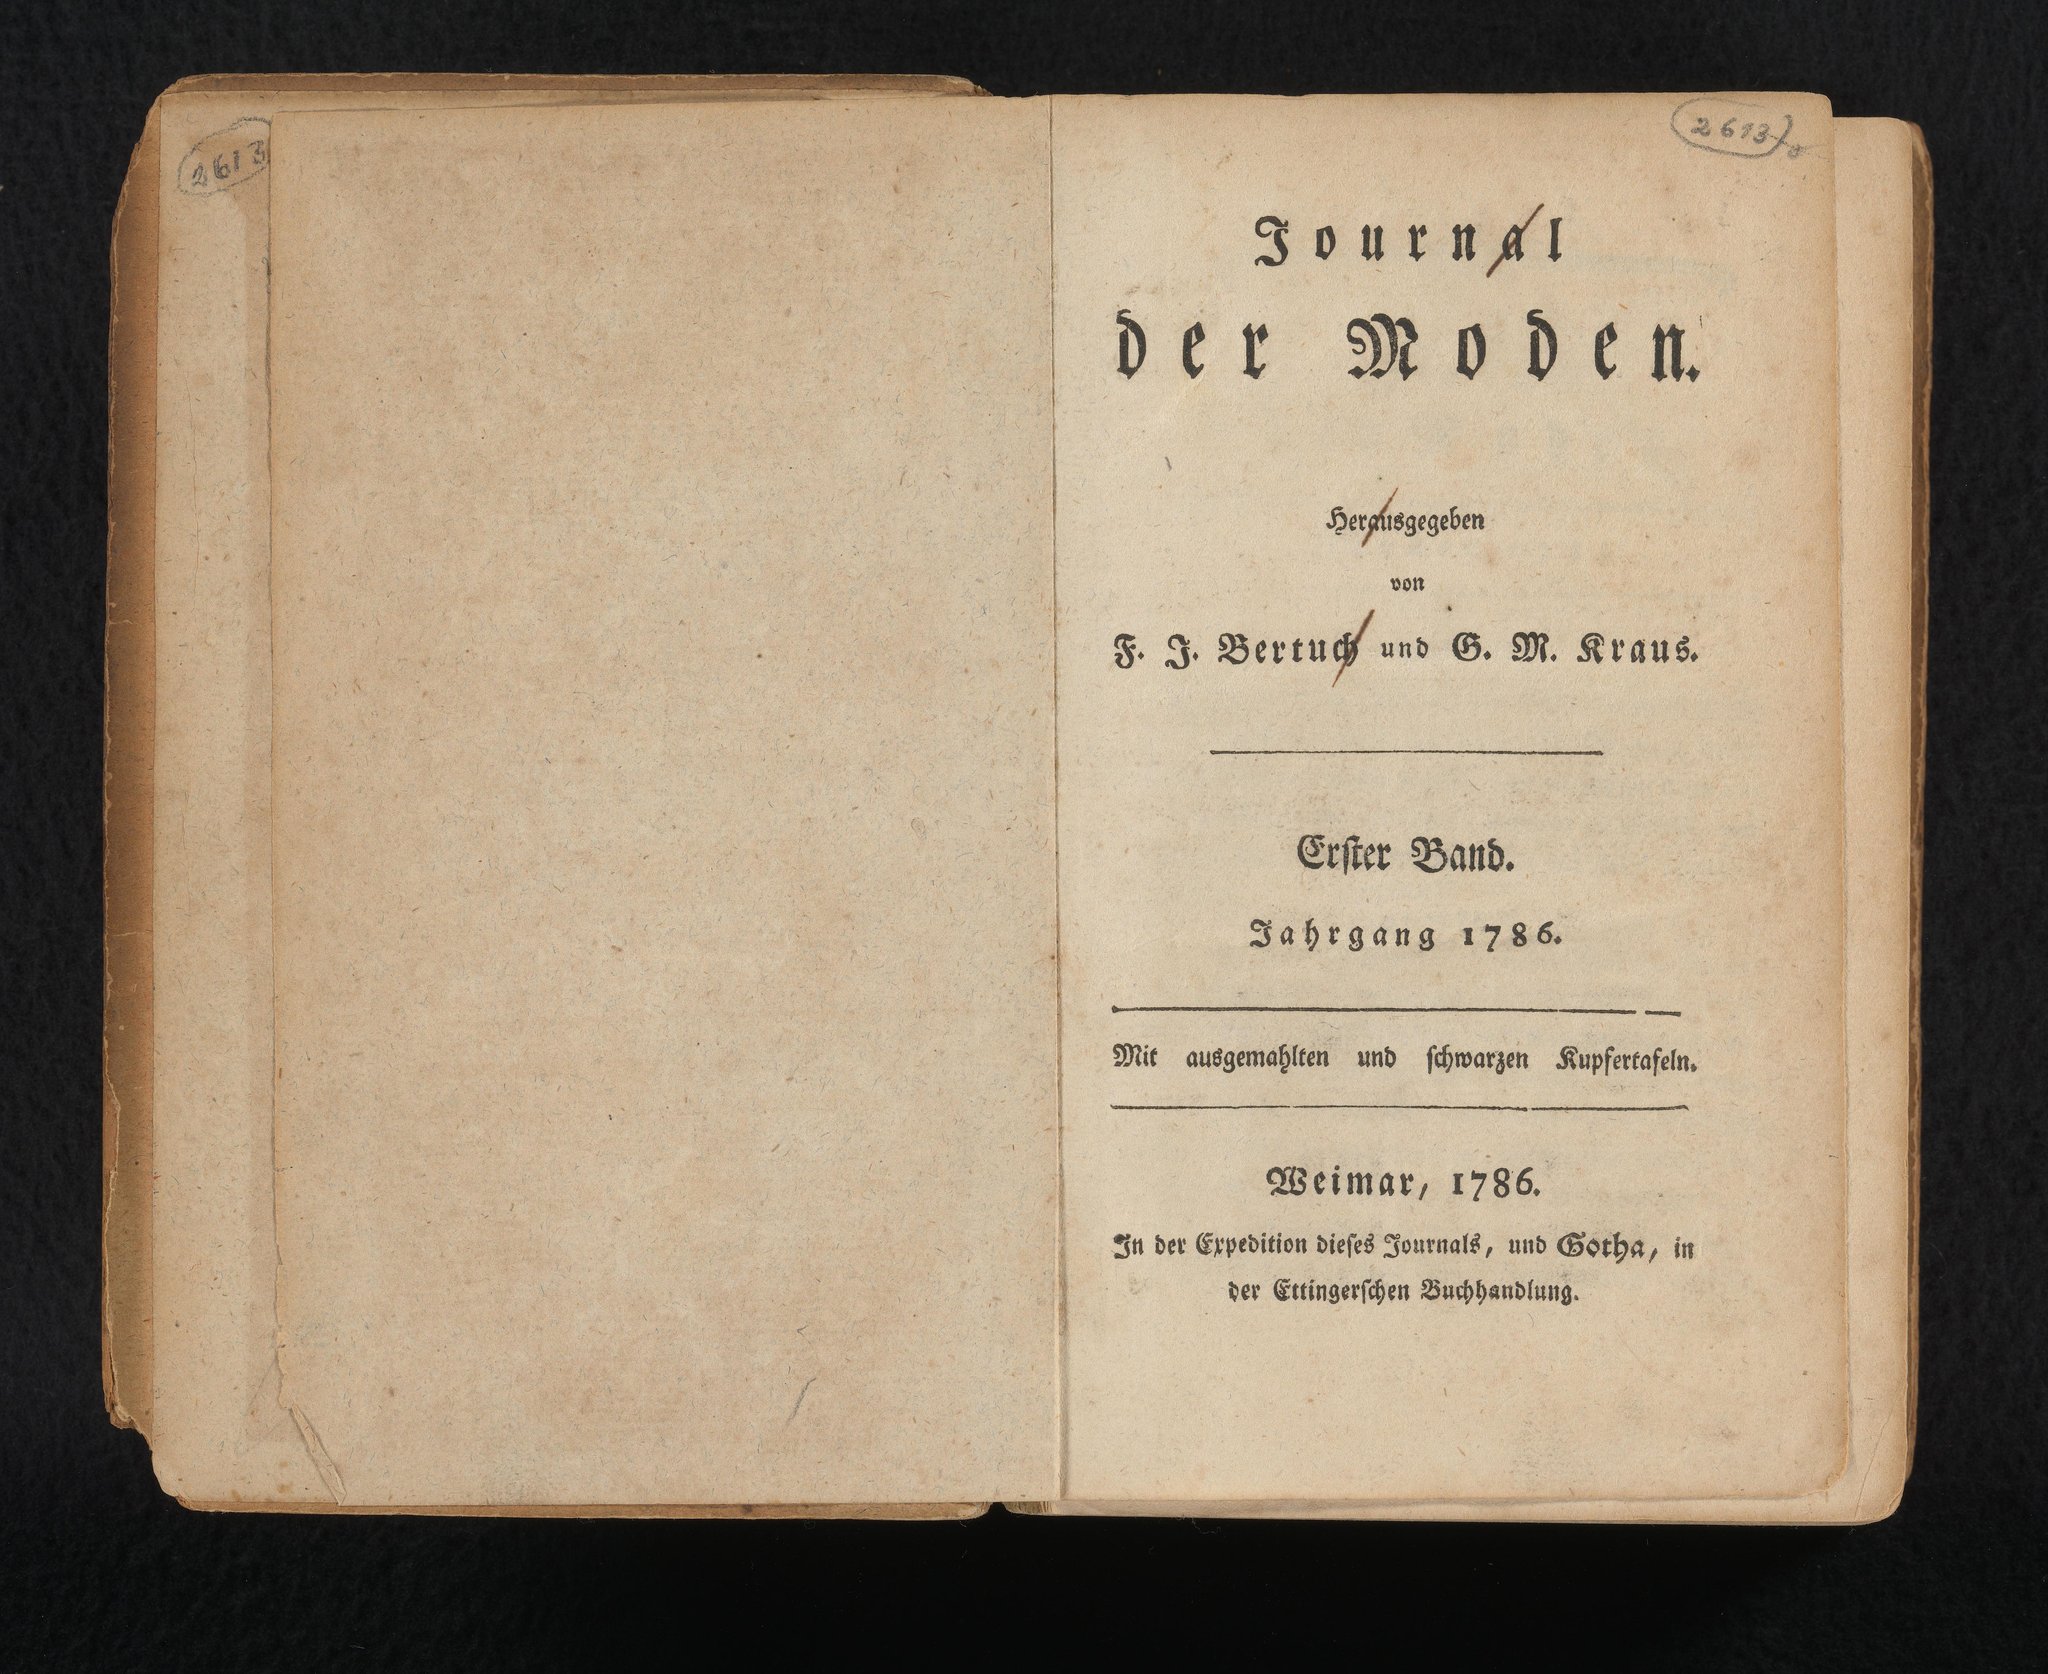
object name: magazine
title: Journal des Luxus und der Moden 1786, Band I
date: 1786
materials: paper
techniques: etching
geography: weimar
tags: fashion plates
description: Prent uit het modetijdschrift Journal des Luxus und der Moden, uitgegeven door Friedrich Justin Bertuch en Georg Melchior Kraus, Weimar, 1786-1826.